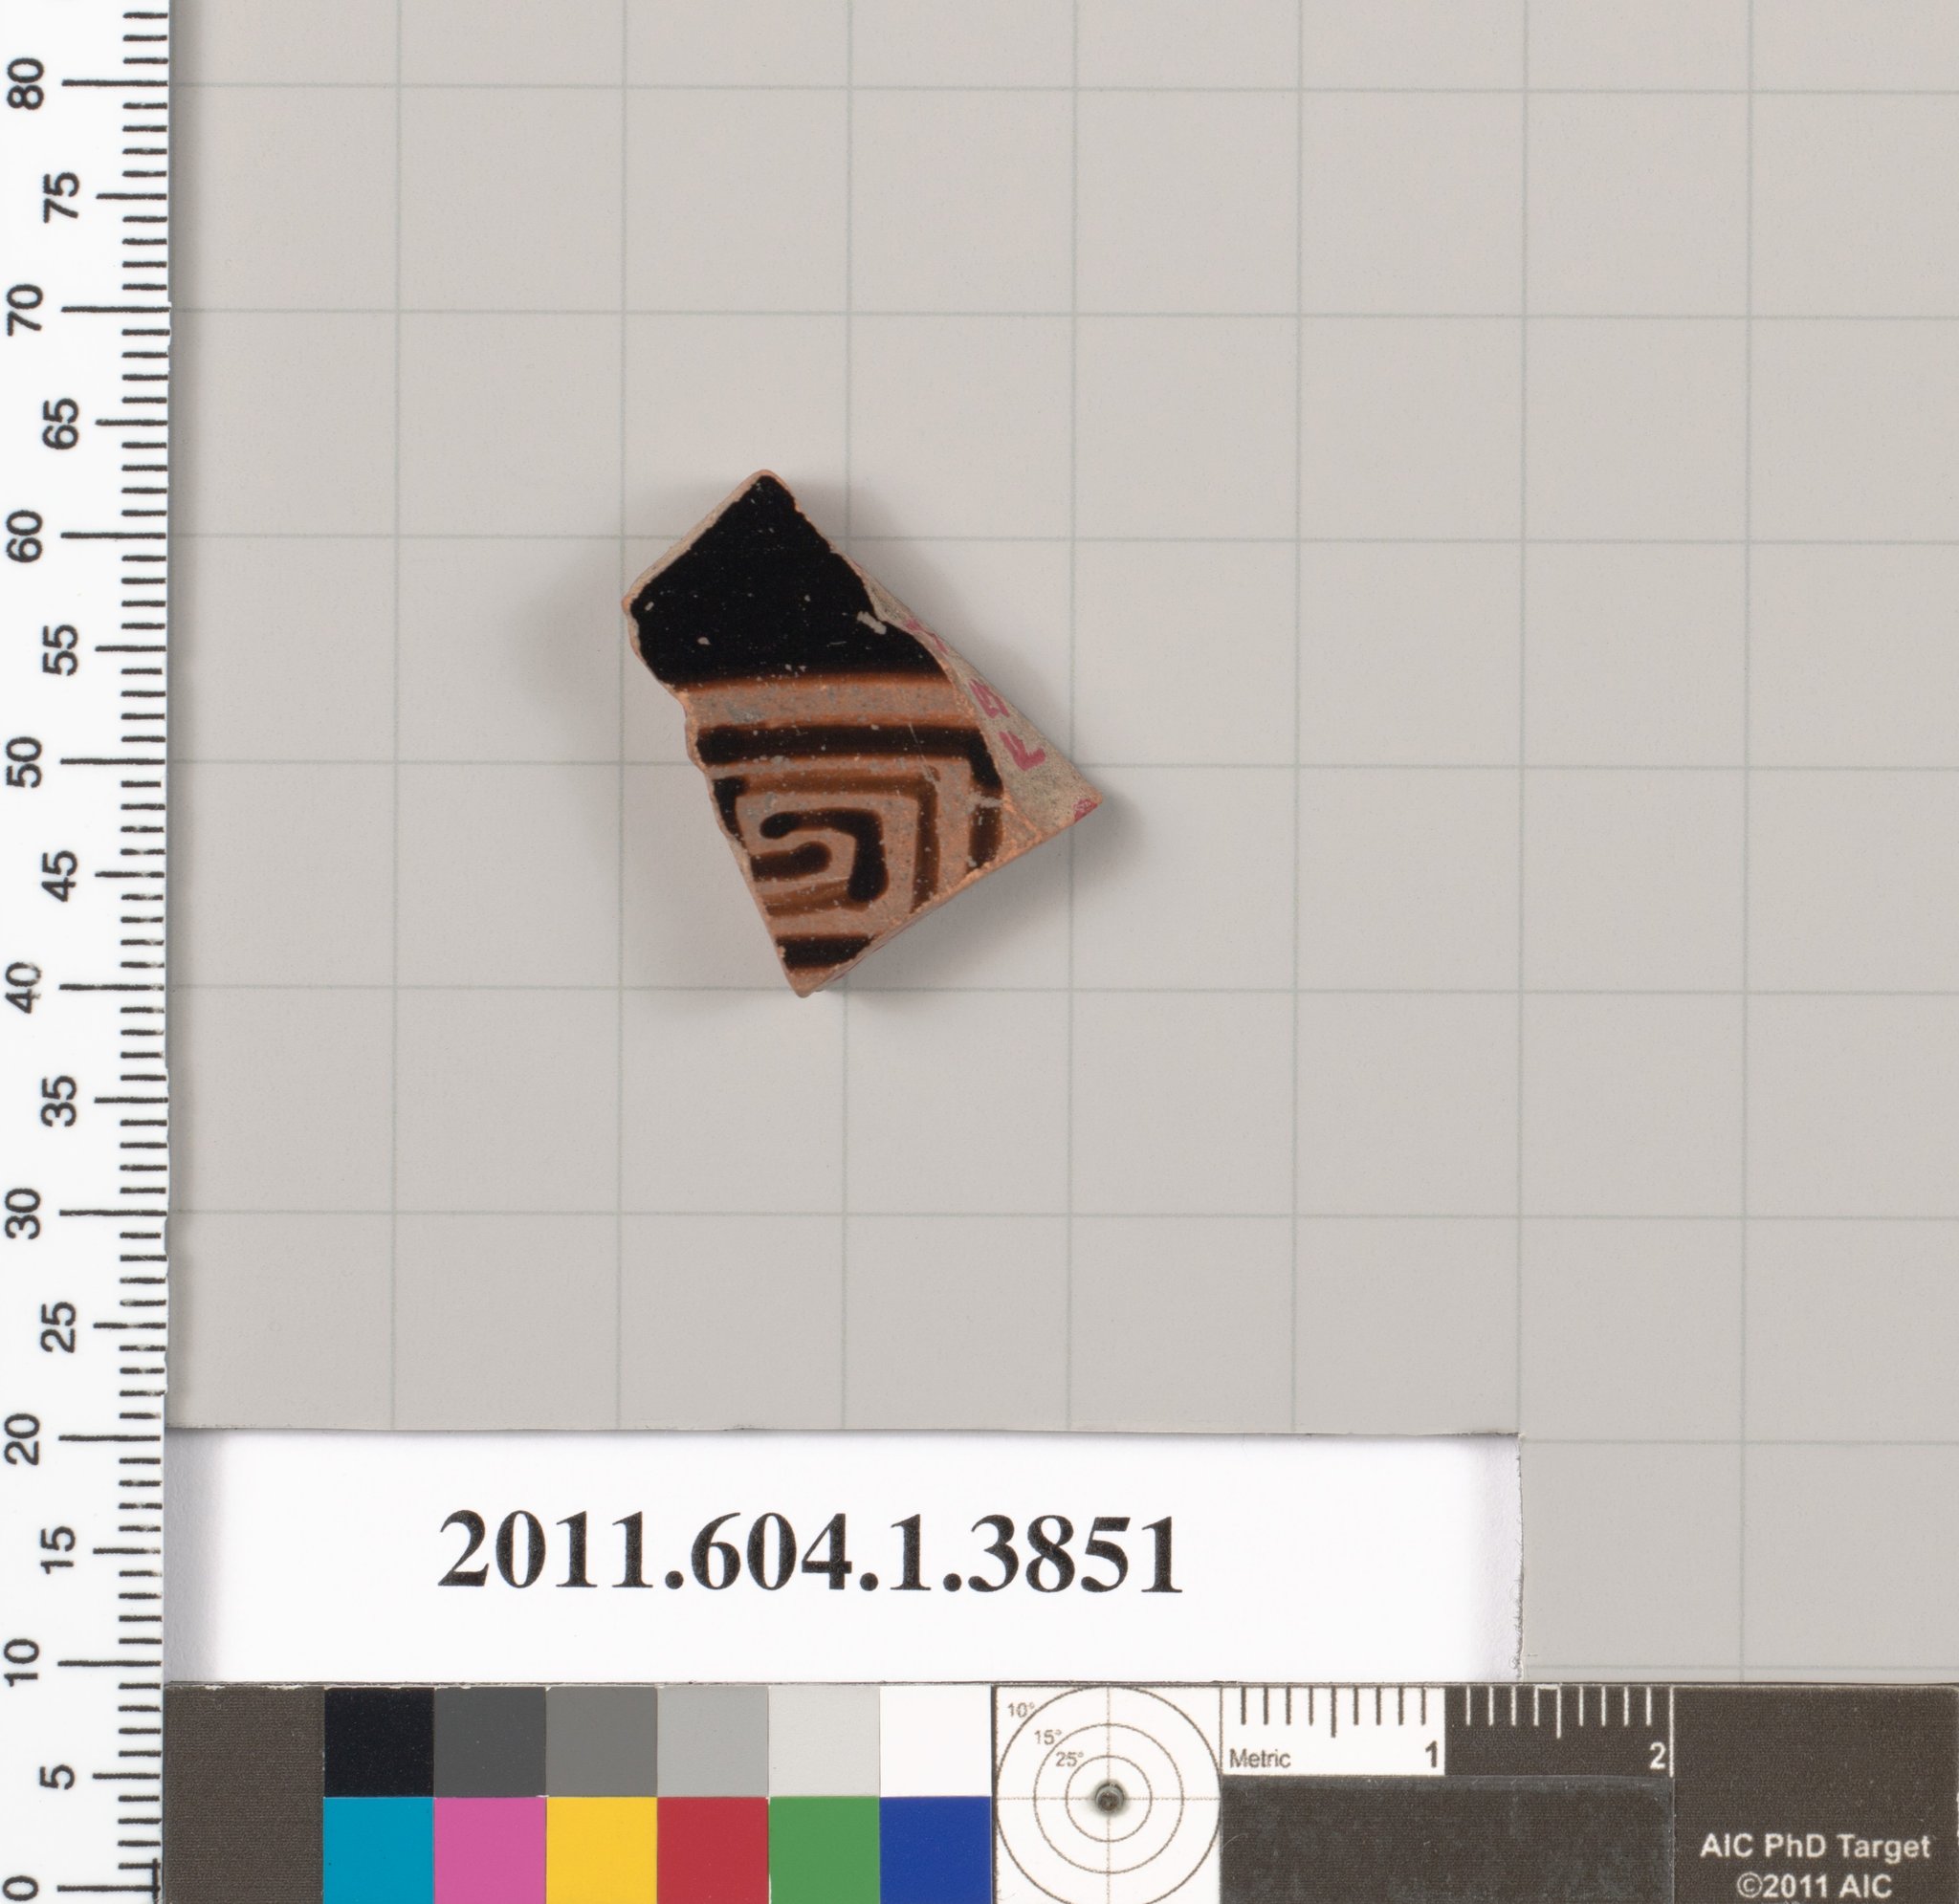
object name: kylix fragment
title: Terracotta fragment of a kylix (drinking cup)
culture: greek, attic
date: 475-451 BCE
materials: terracotta